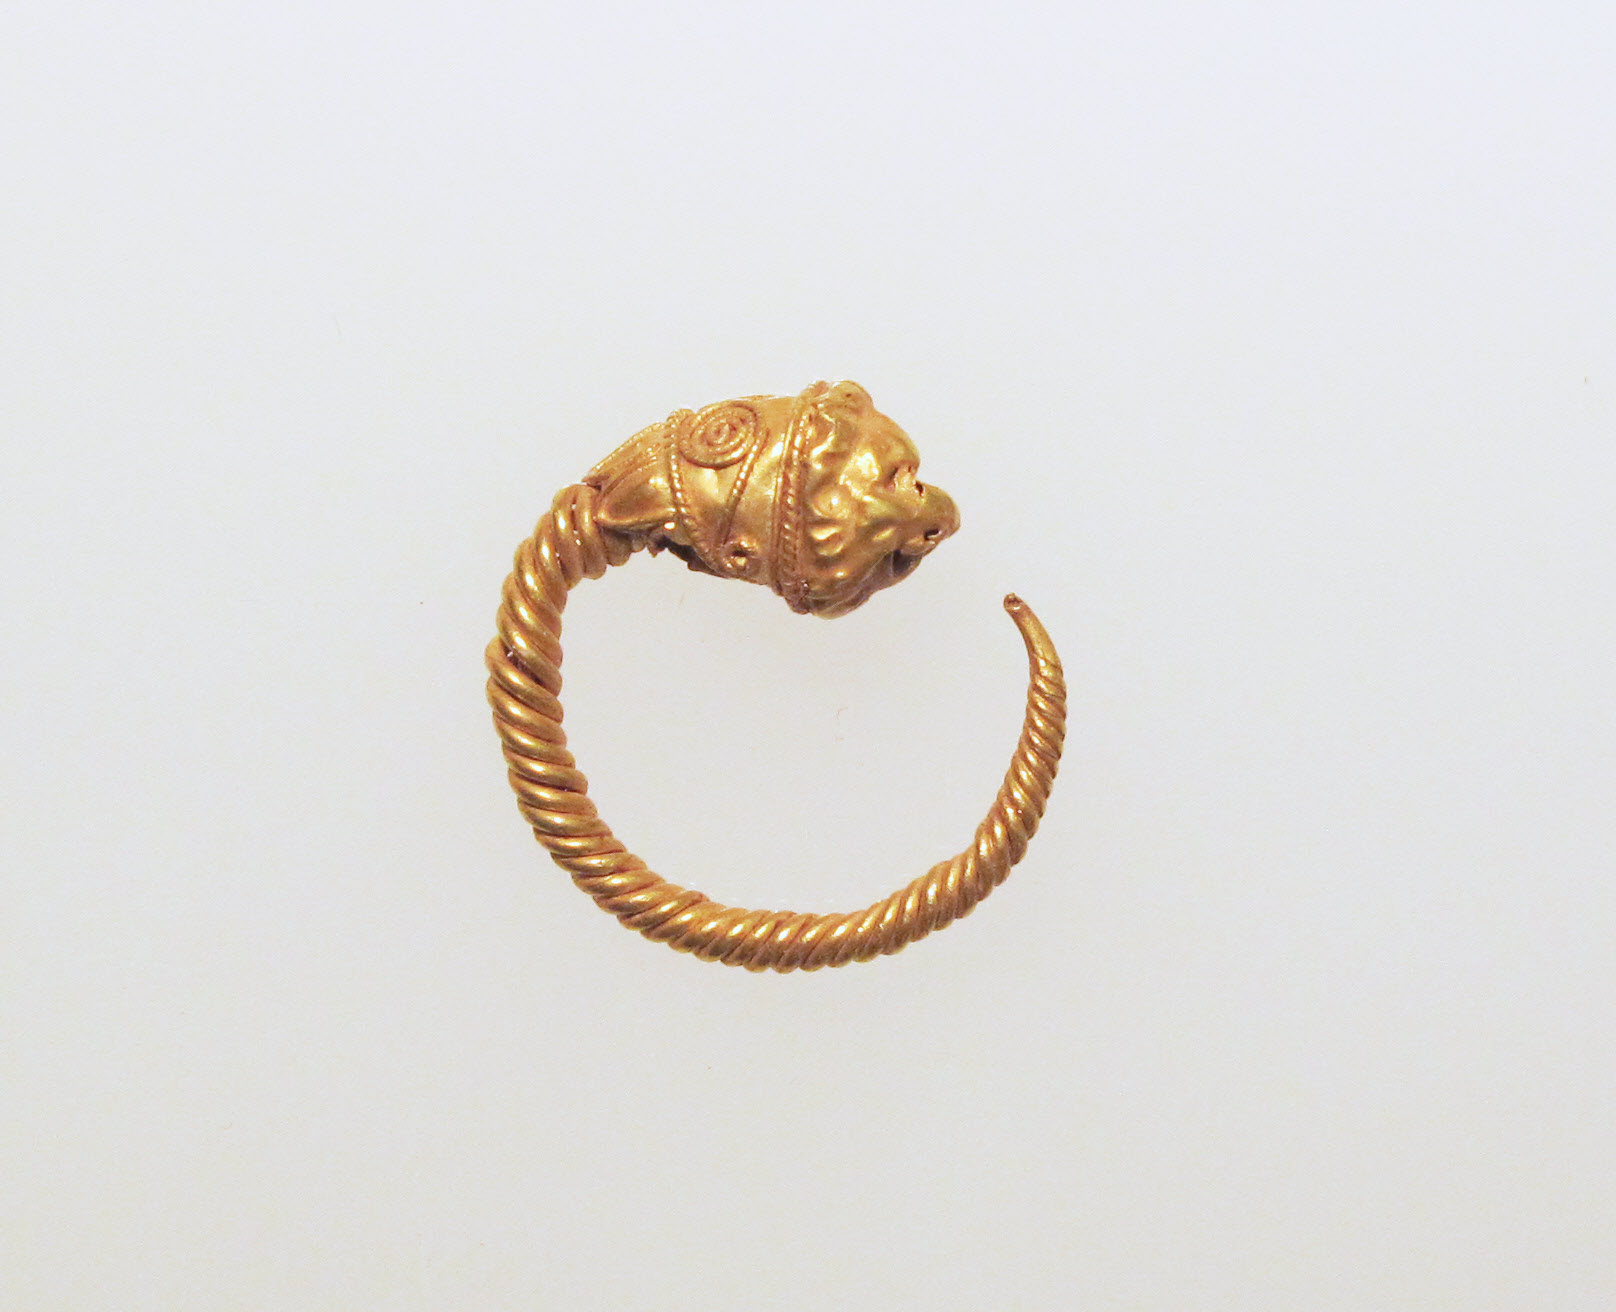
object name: earring with head of lion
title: Gold earring with head of a lion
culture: greek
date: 400-201 BCE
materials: gold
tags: lions